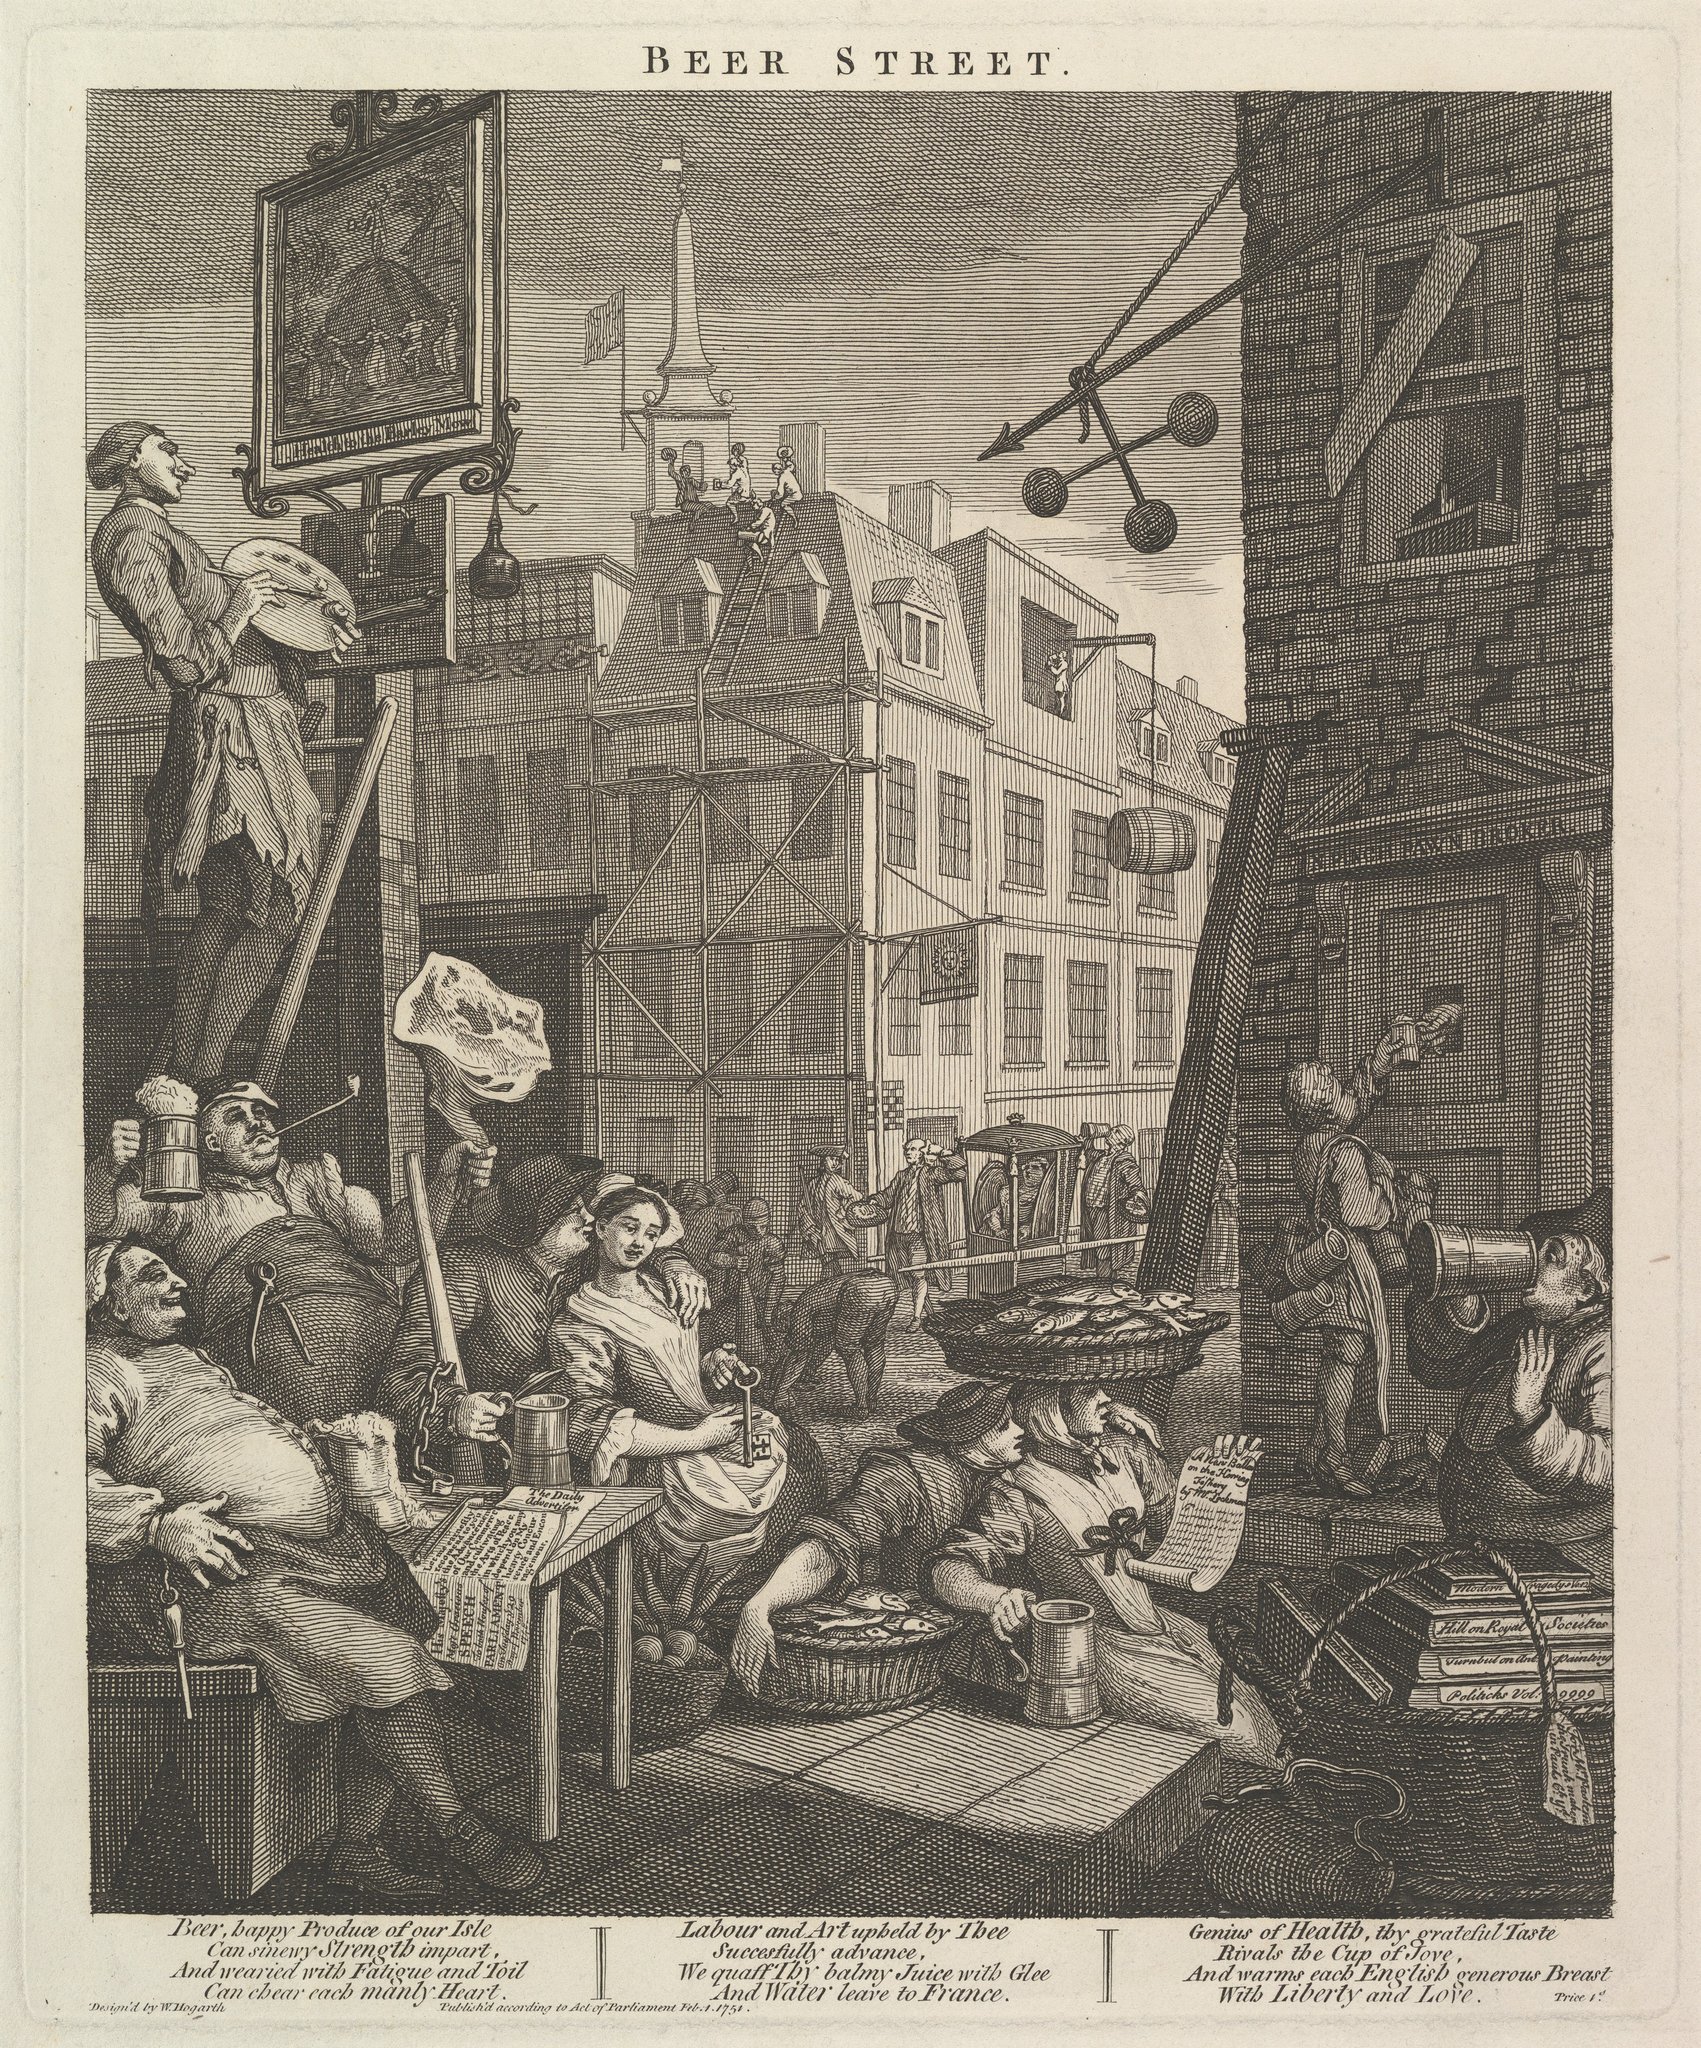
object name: print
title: Beer Street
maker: william hogarth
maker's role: artist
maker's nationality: british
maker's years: 1697-1764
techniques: engraving, etching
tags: streets,men,women,drinking